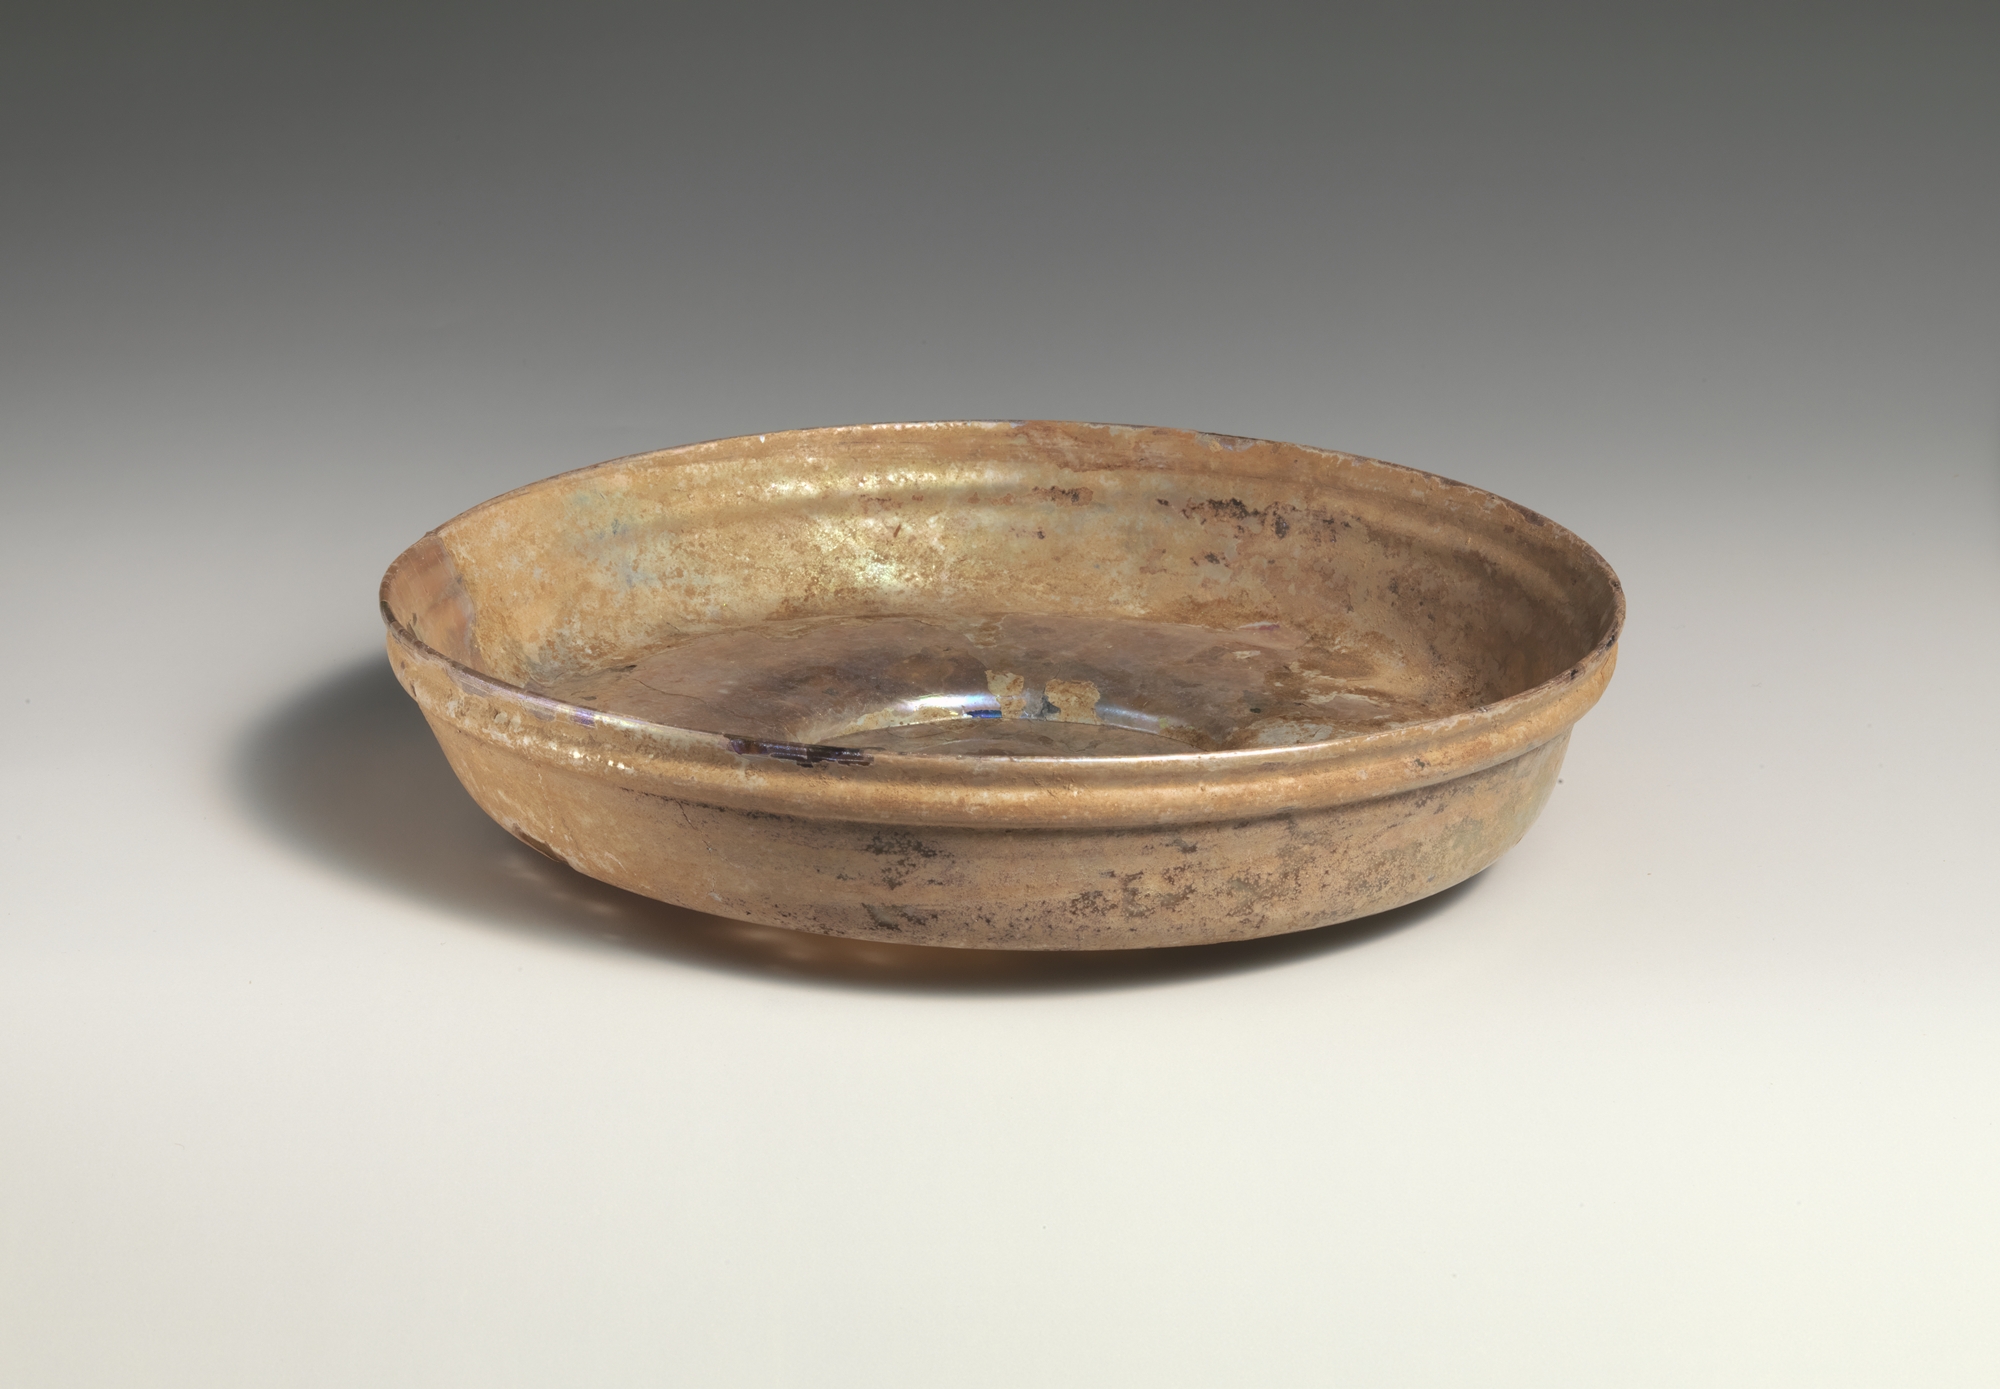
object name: dish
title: Glass dish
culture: roman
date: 301-400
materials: glass